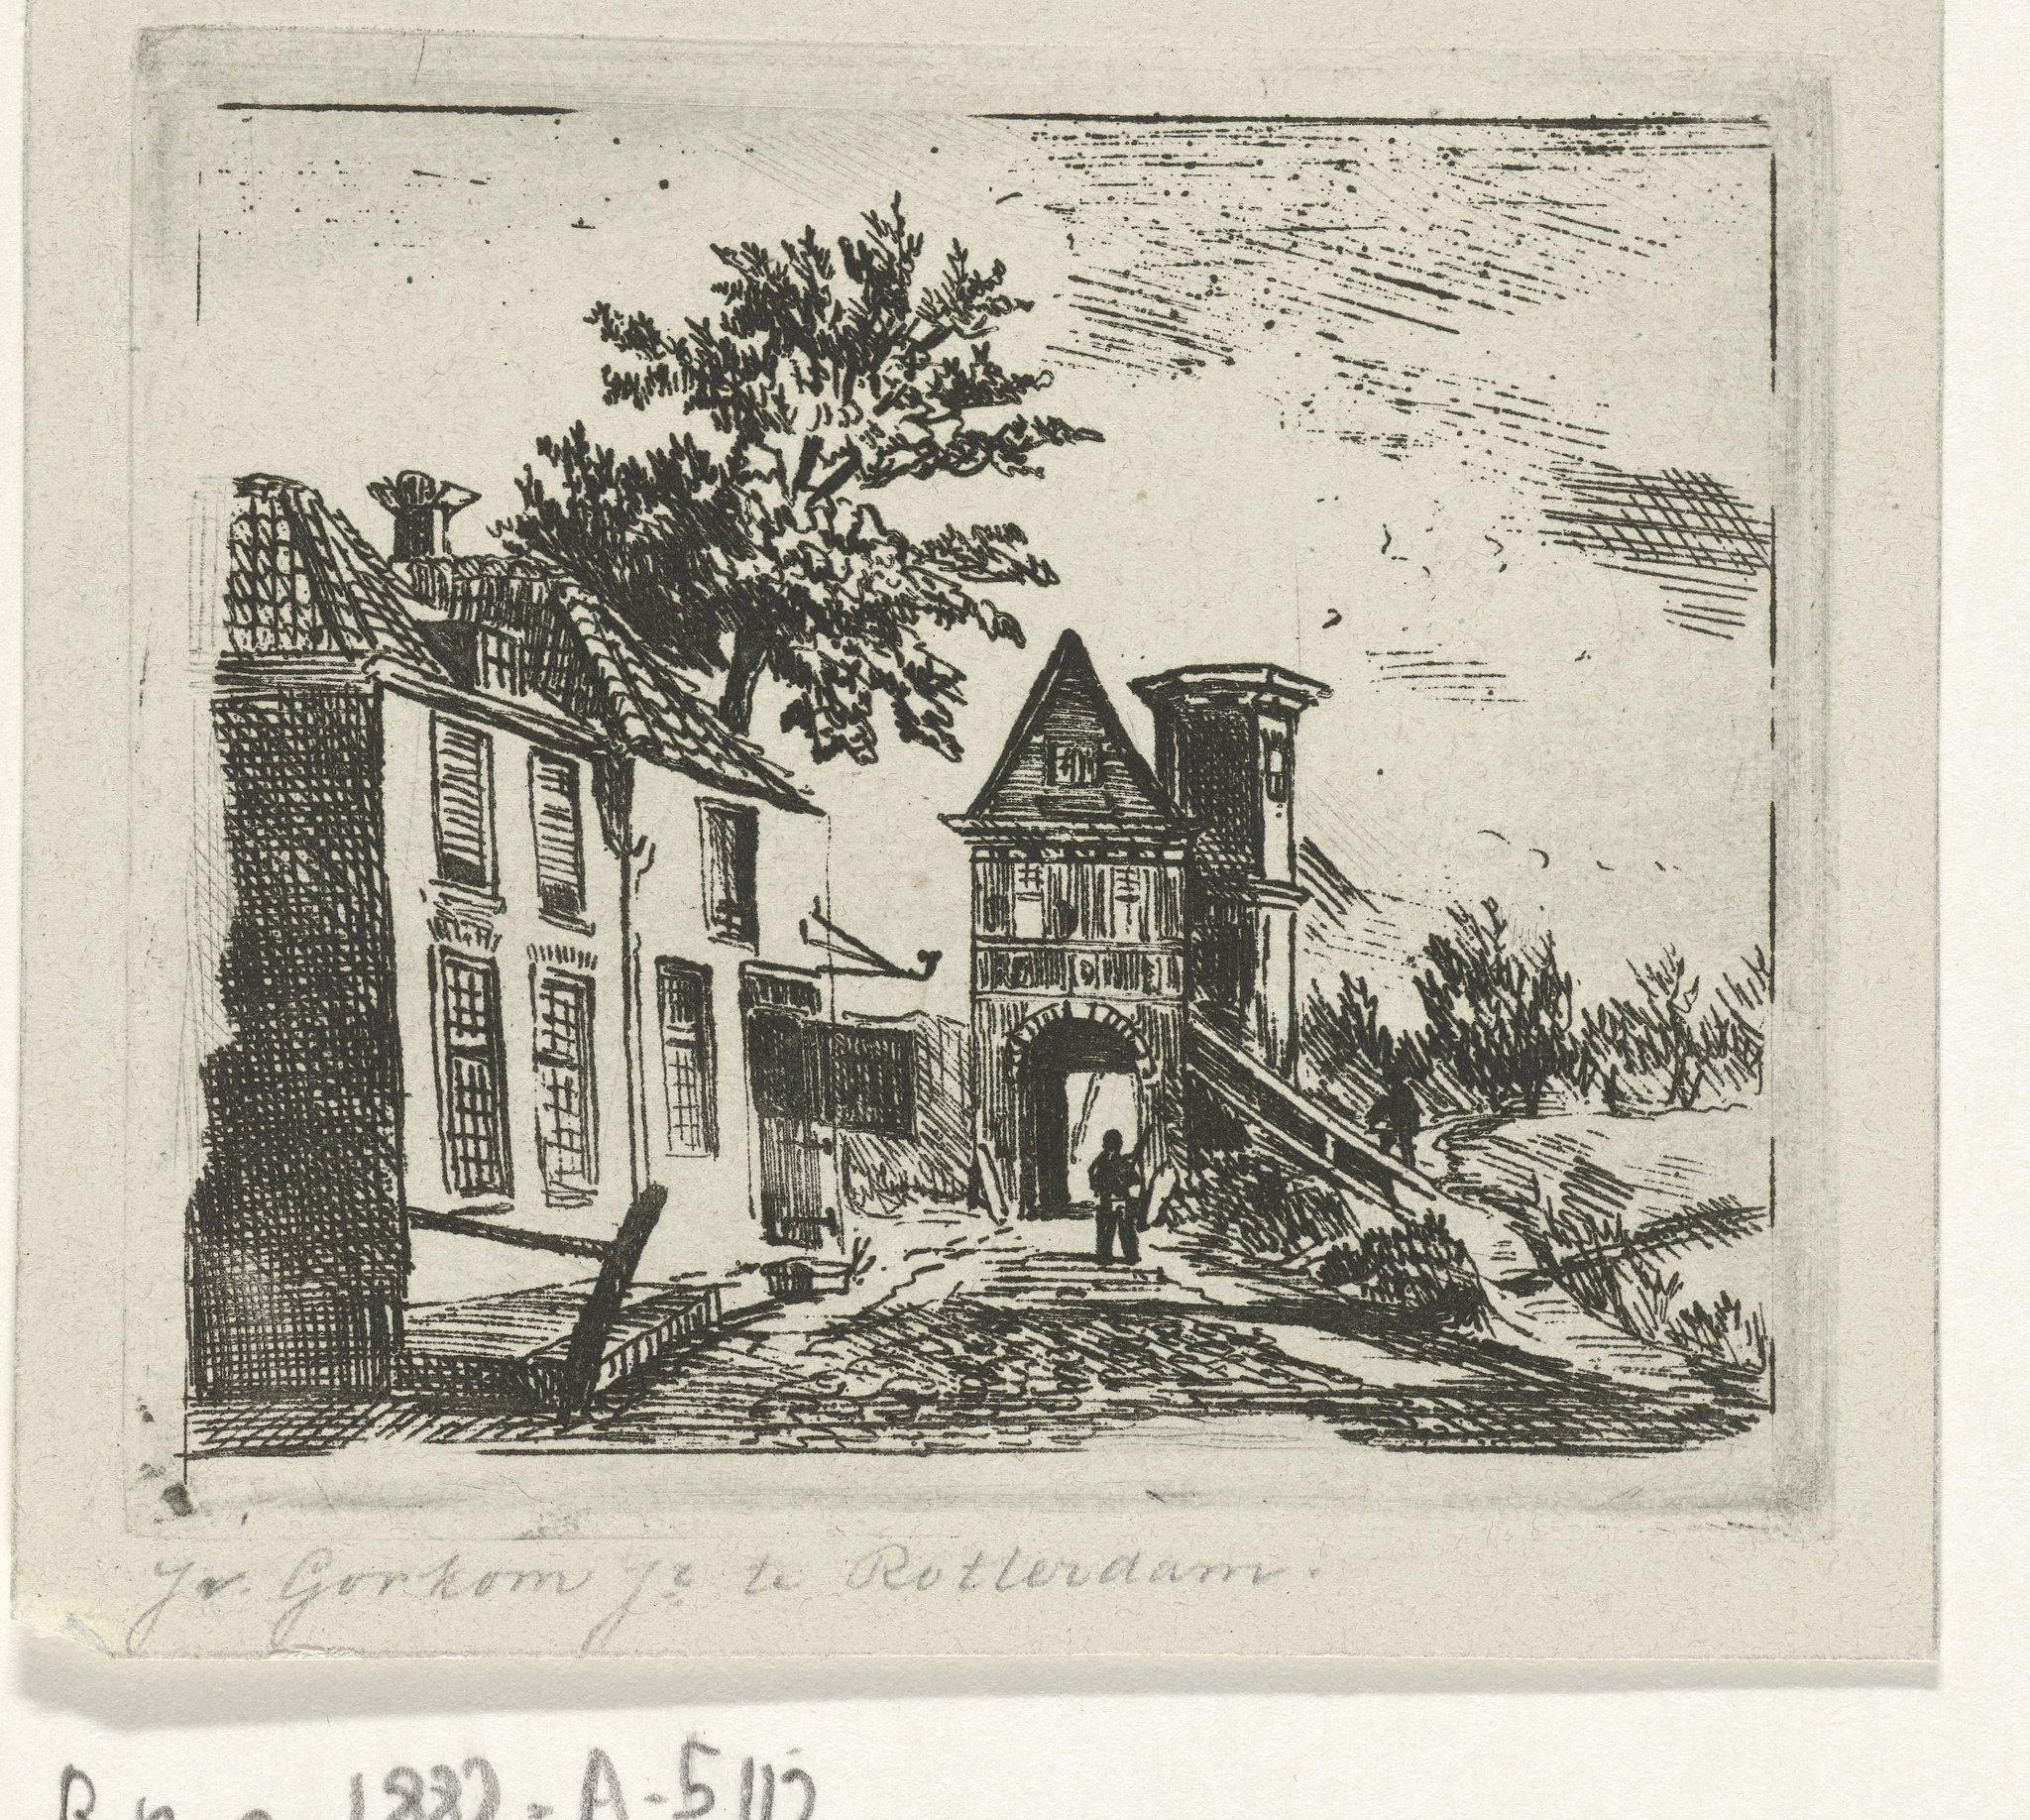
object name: print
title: Stadsgezicht met poort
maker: jacobus van gorkom (jr.)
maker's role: print maker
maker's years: 1827-1880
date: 1837-1880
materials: paper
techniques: etching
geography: rotterdam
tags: street, city-gate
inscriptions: collector's mark: Lugt 2227, collector's mark: ‘J. v. Gorkom Jr. te Rotterdam’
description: Straat in een stad met in de verte een poort, waarnaast een toren. Links een huis.